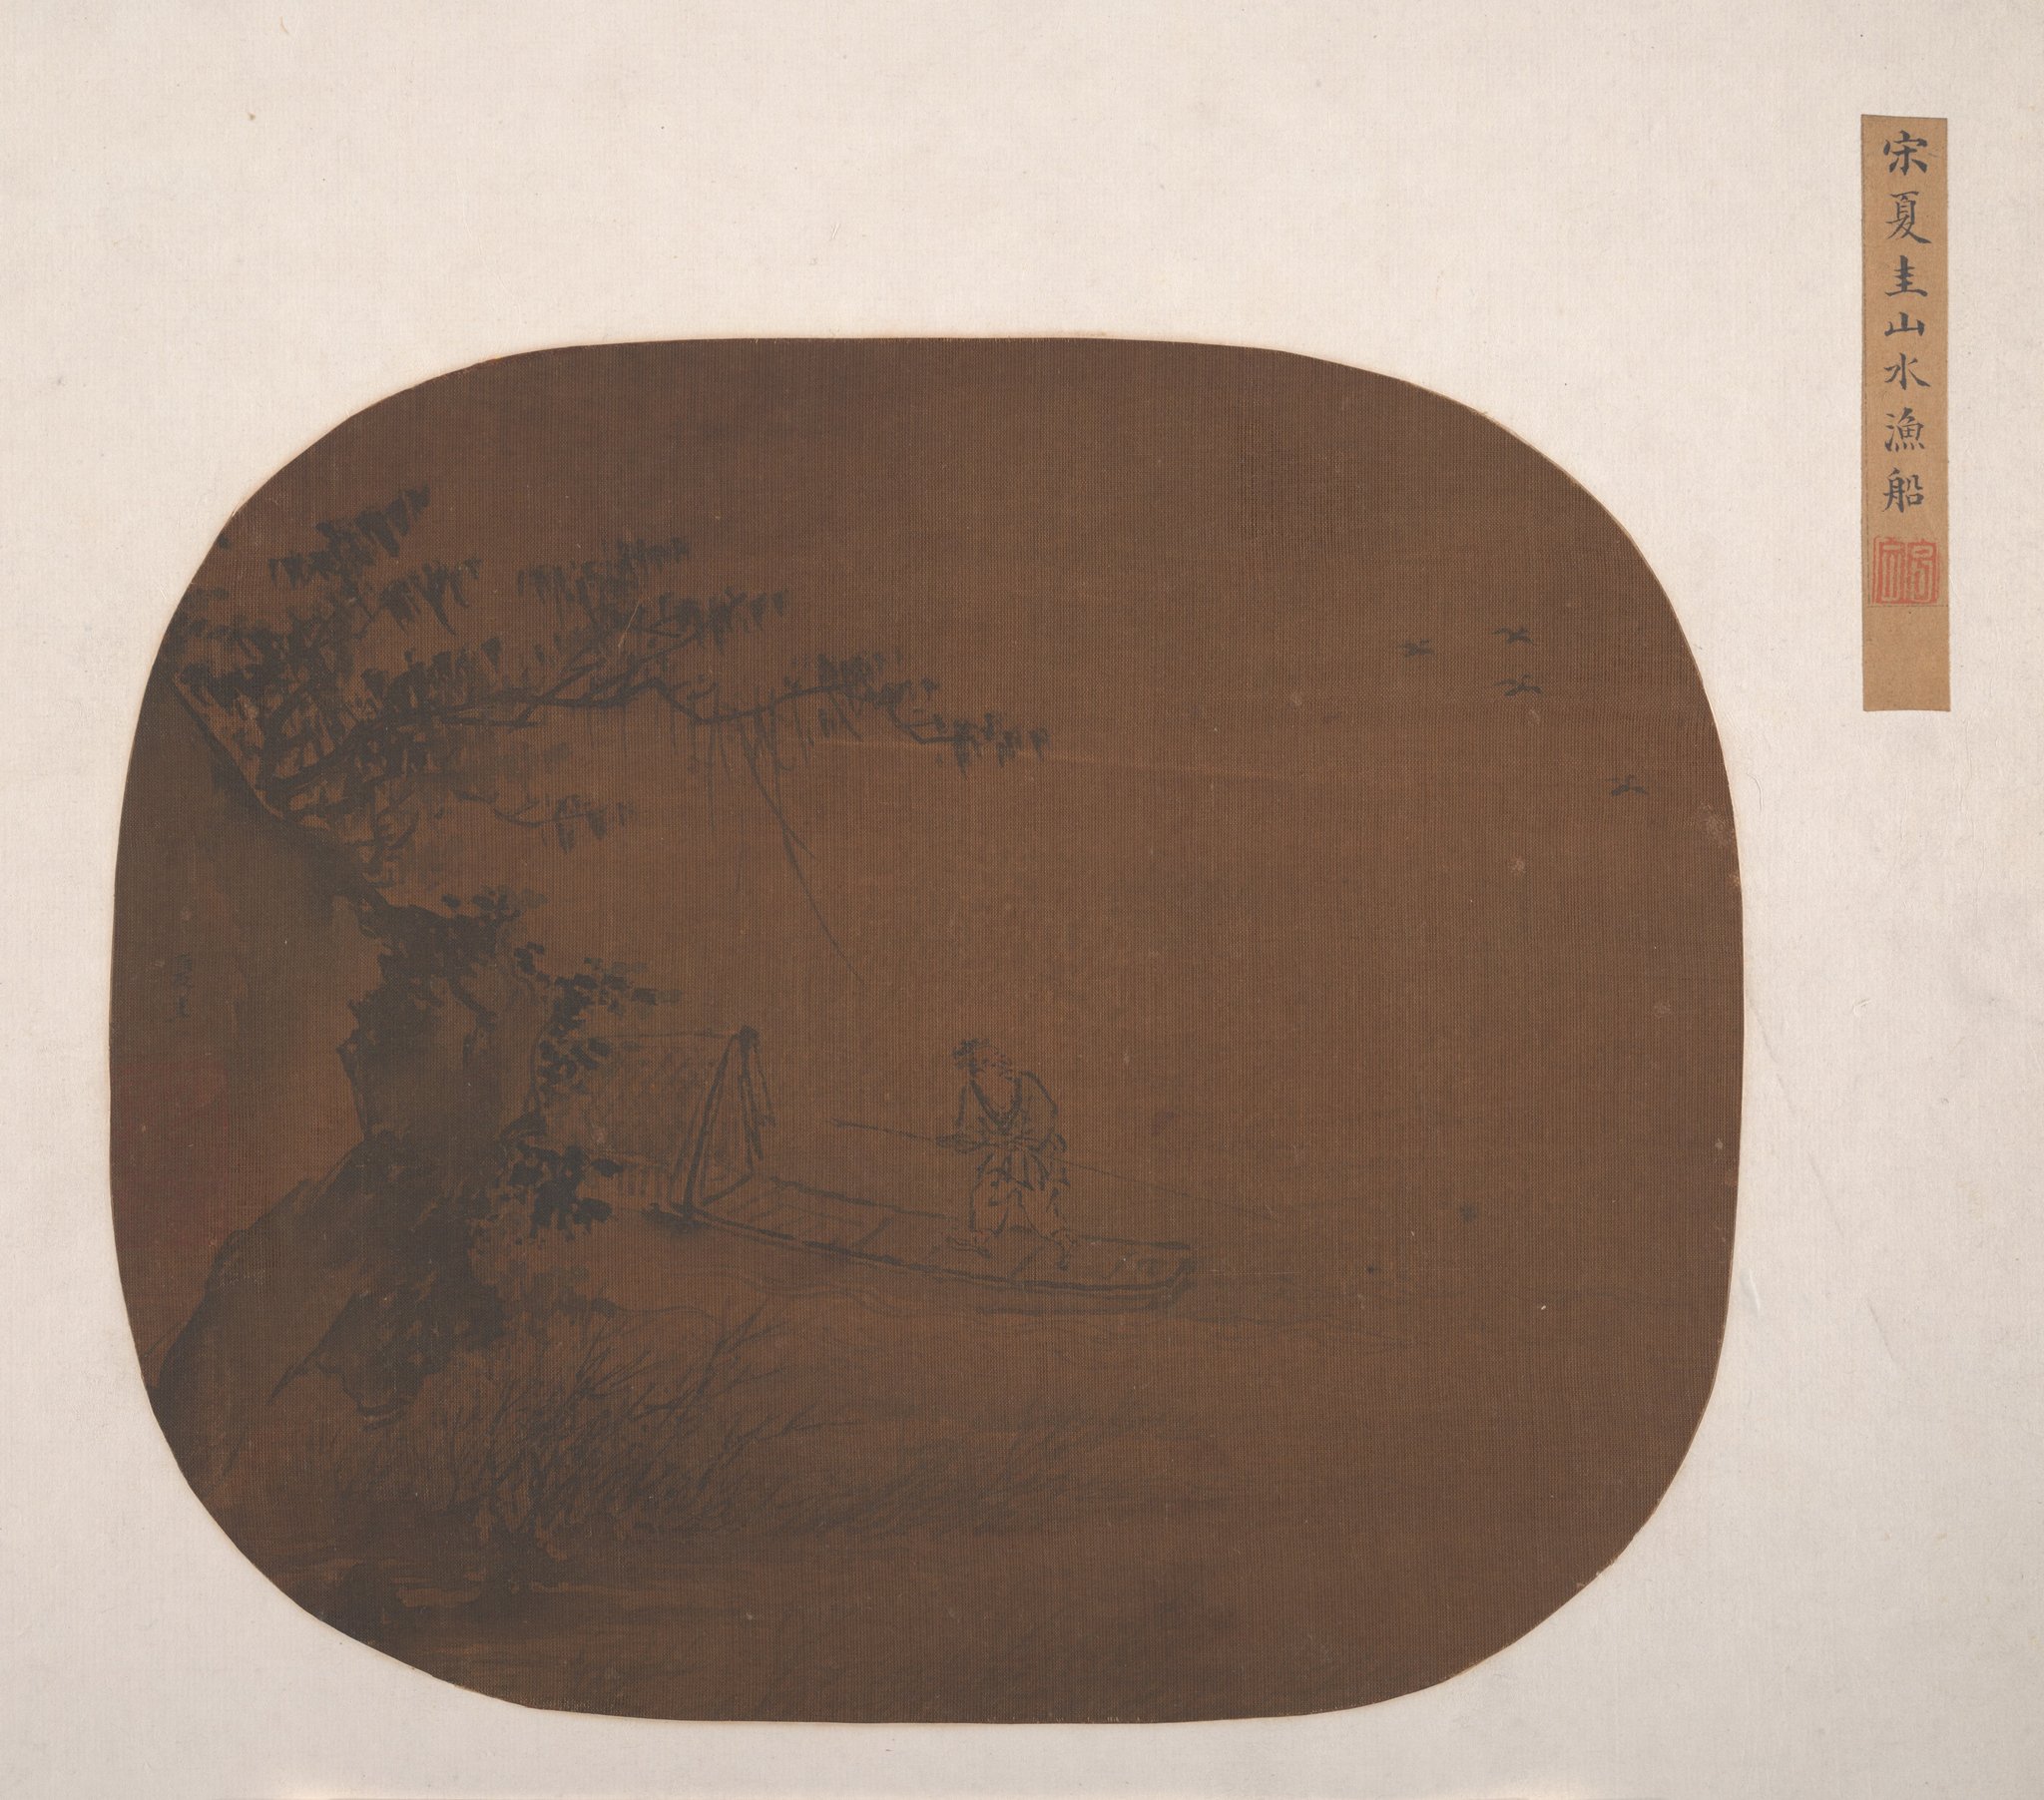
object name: fan mounted a an album leaf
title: Boatman in Rocky Cove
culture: chinese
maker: unidentified artist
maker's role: artist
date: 1368-1911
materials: ink, silk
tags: men,boats